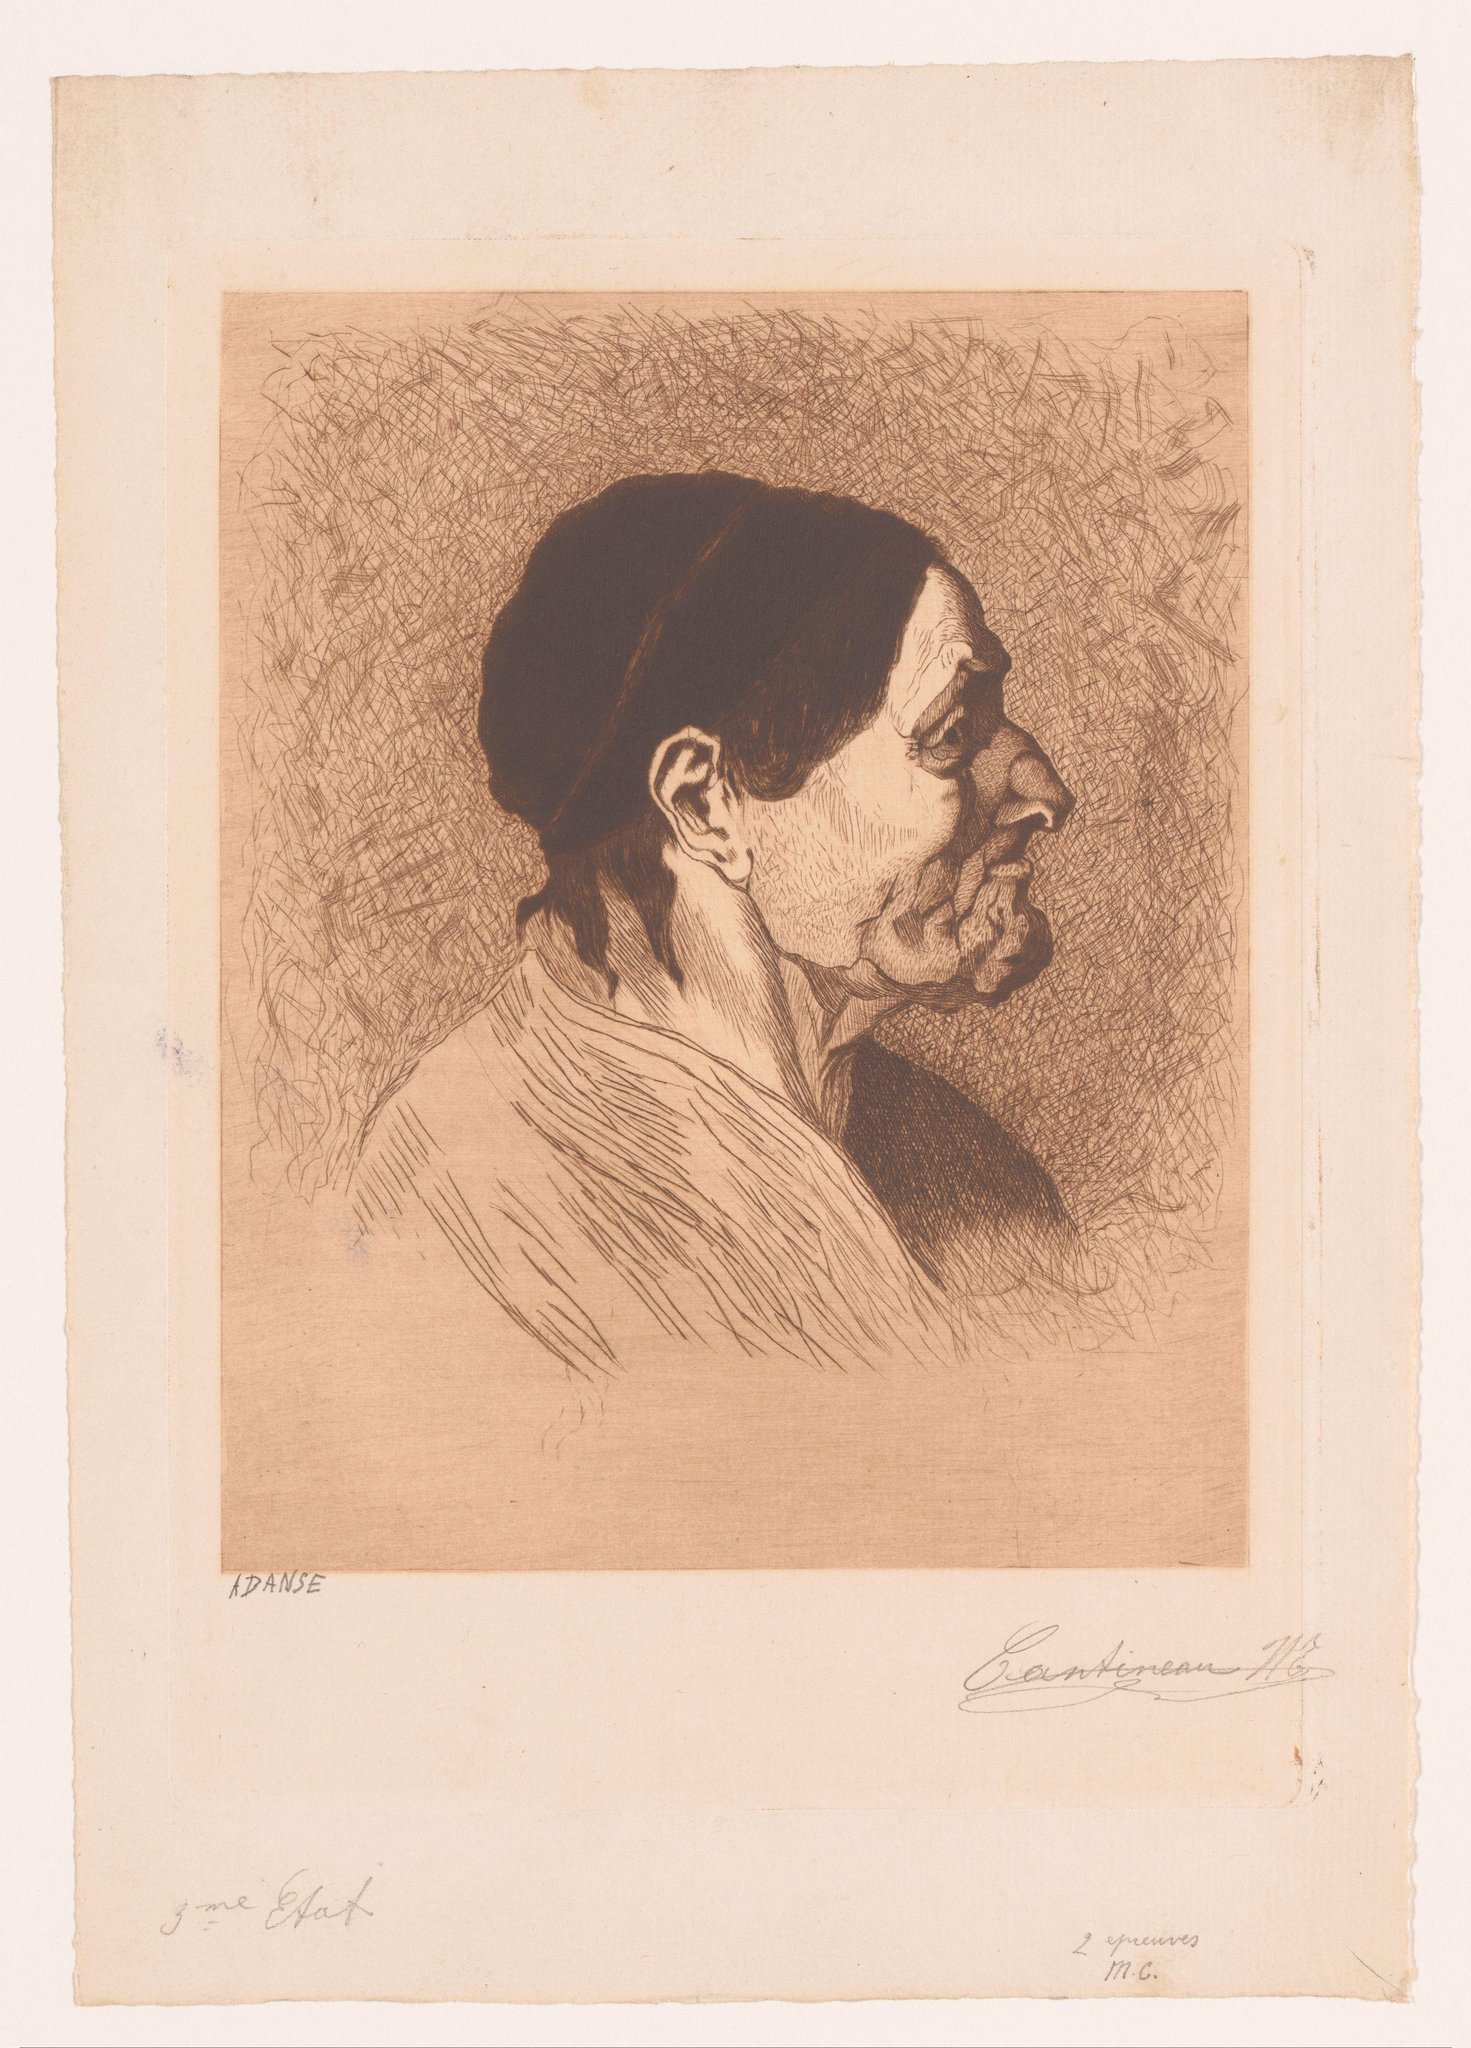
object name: print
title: Portret van een onbekende oude vrouw, en profil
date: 1894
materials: paper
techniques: etching, intaglio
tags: old woman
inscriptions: annotation: ‘3me état’, annotation: ‘2 eupreuves M.C.’, collector's mark: Lugt 2228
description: Sterfdatum prentmaker onbekend. Derhalve zijn voor bepaling van de rechten van dit object de vervaardigings- en verwervingsdatum aangehouden.